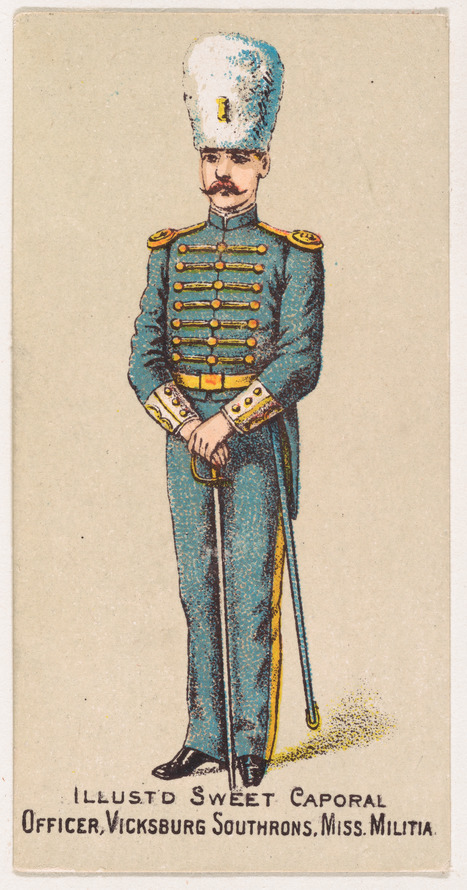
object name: print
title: Officer, Vicksburg, Southrons, Mississippi Militia, from the Military Series (N224) issued by Kinney Tobacco Company to promote Sweet Caporal Cigarettes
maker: kinney brothers tobacco company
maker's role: publisher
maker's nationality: american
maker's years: 1869-2011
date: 1888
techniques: color lithograph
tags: soldiers,swords,men